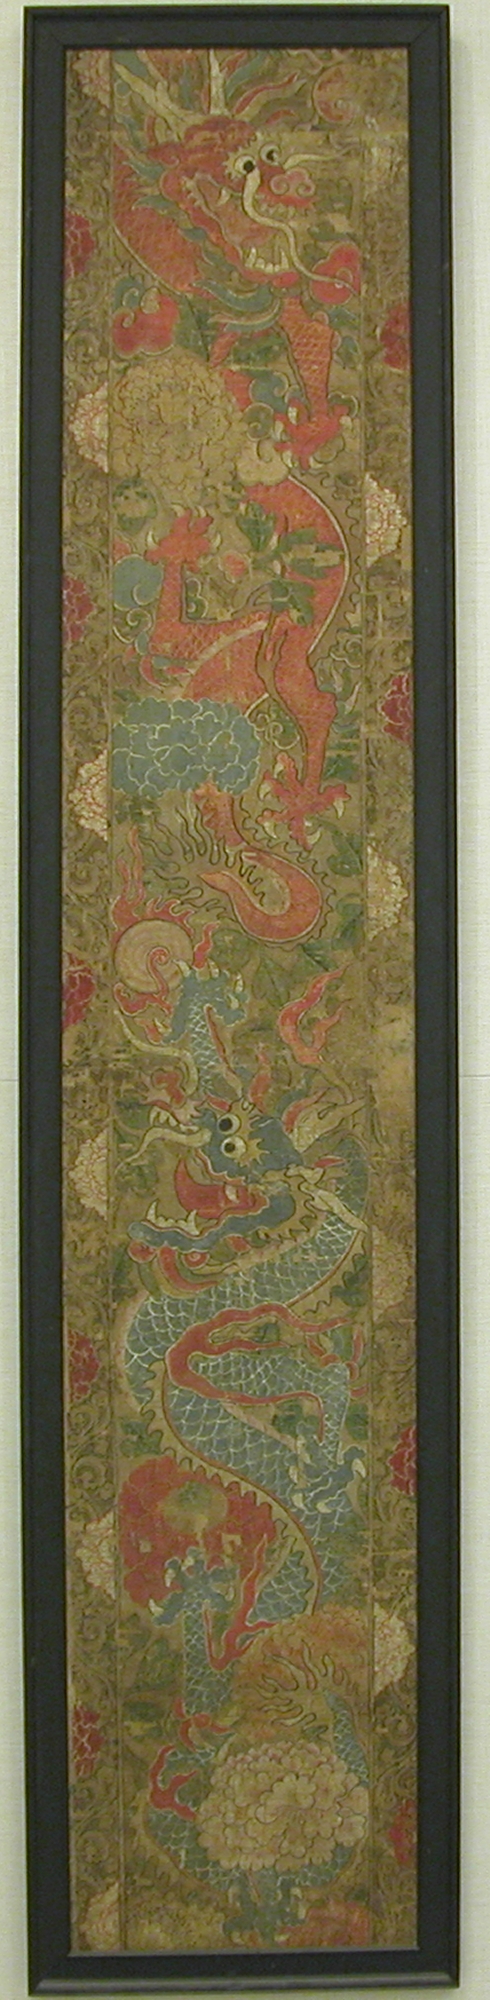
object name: painting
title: Dragons Playing with the Sacred Pearl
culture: korean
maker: unidentified artist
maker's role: artist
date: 1501-1600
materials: ink, paper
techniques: painting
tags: dragons